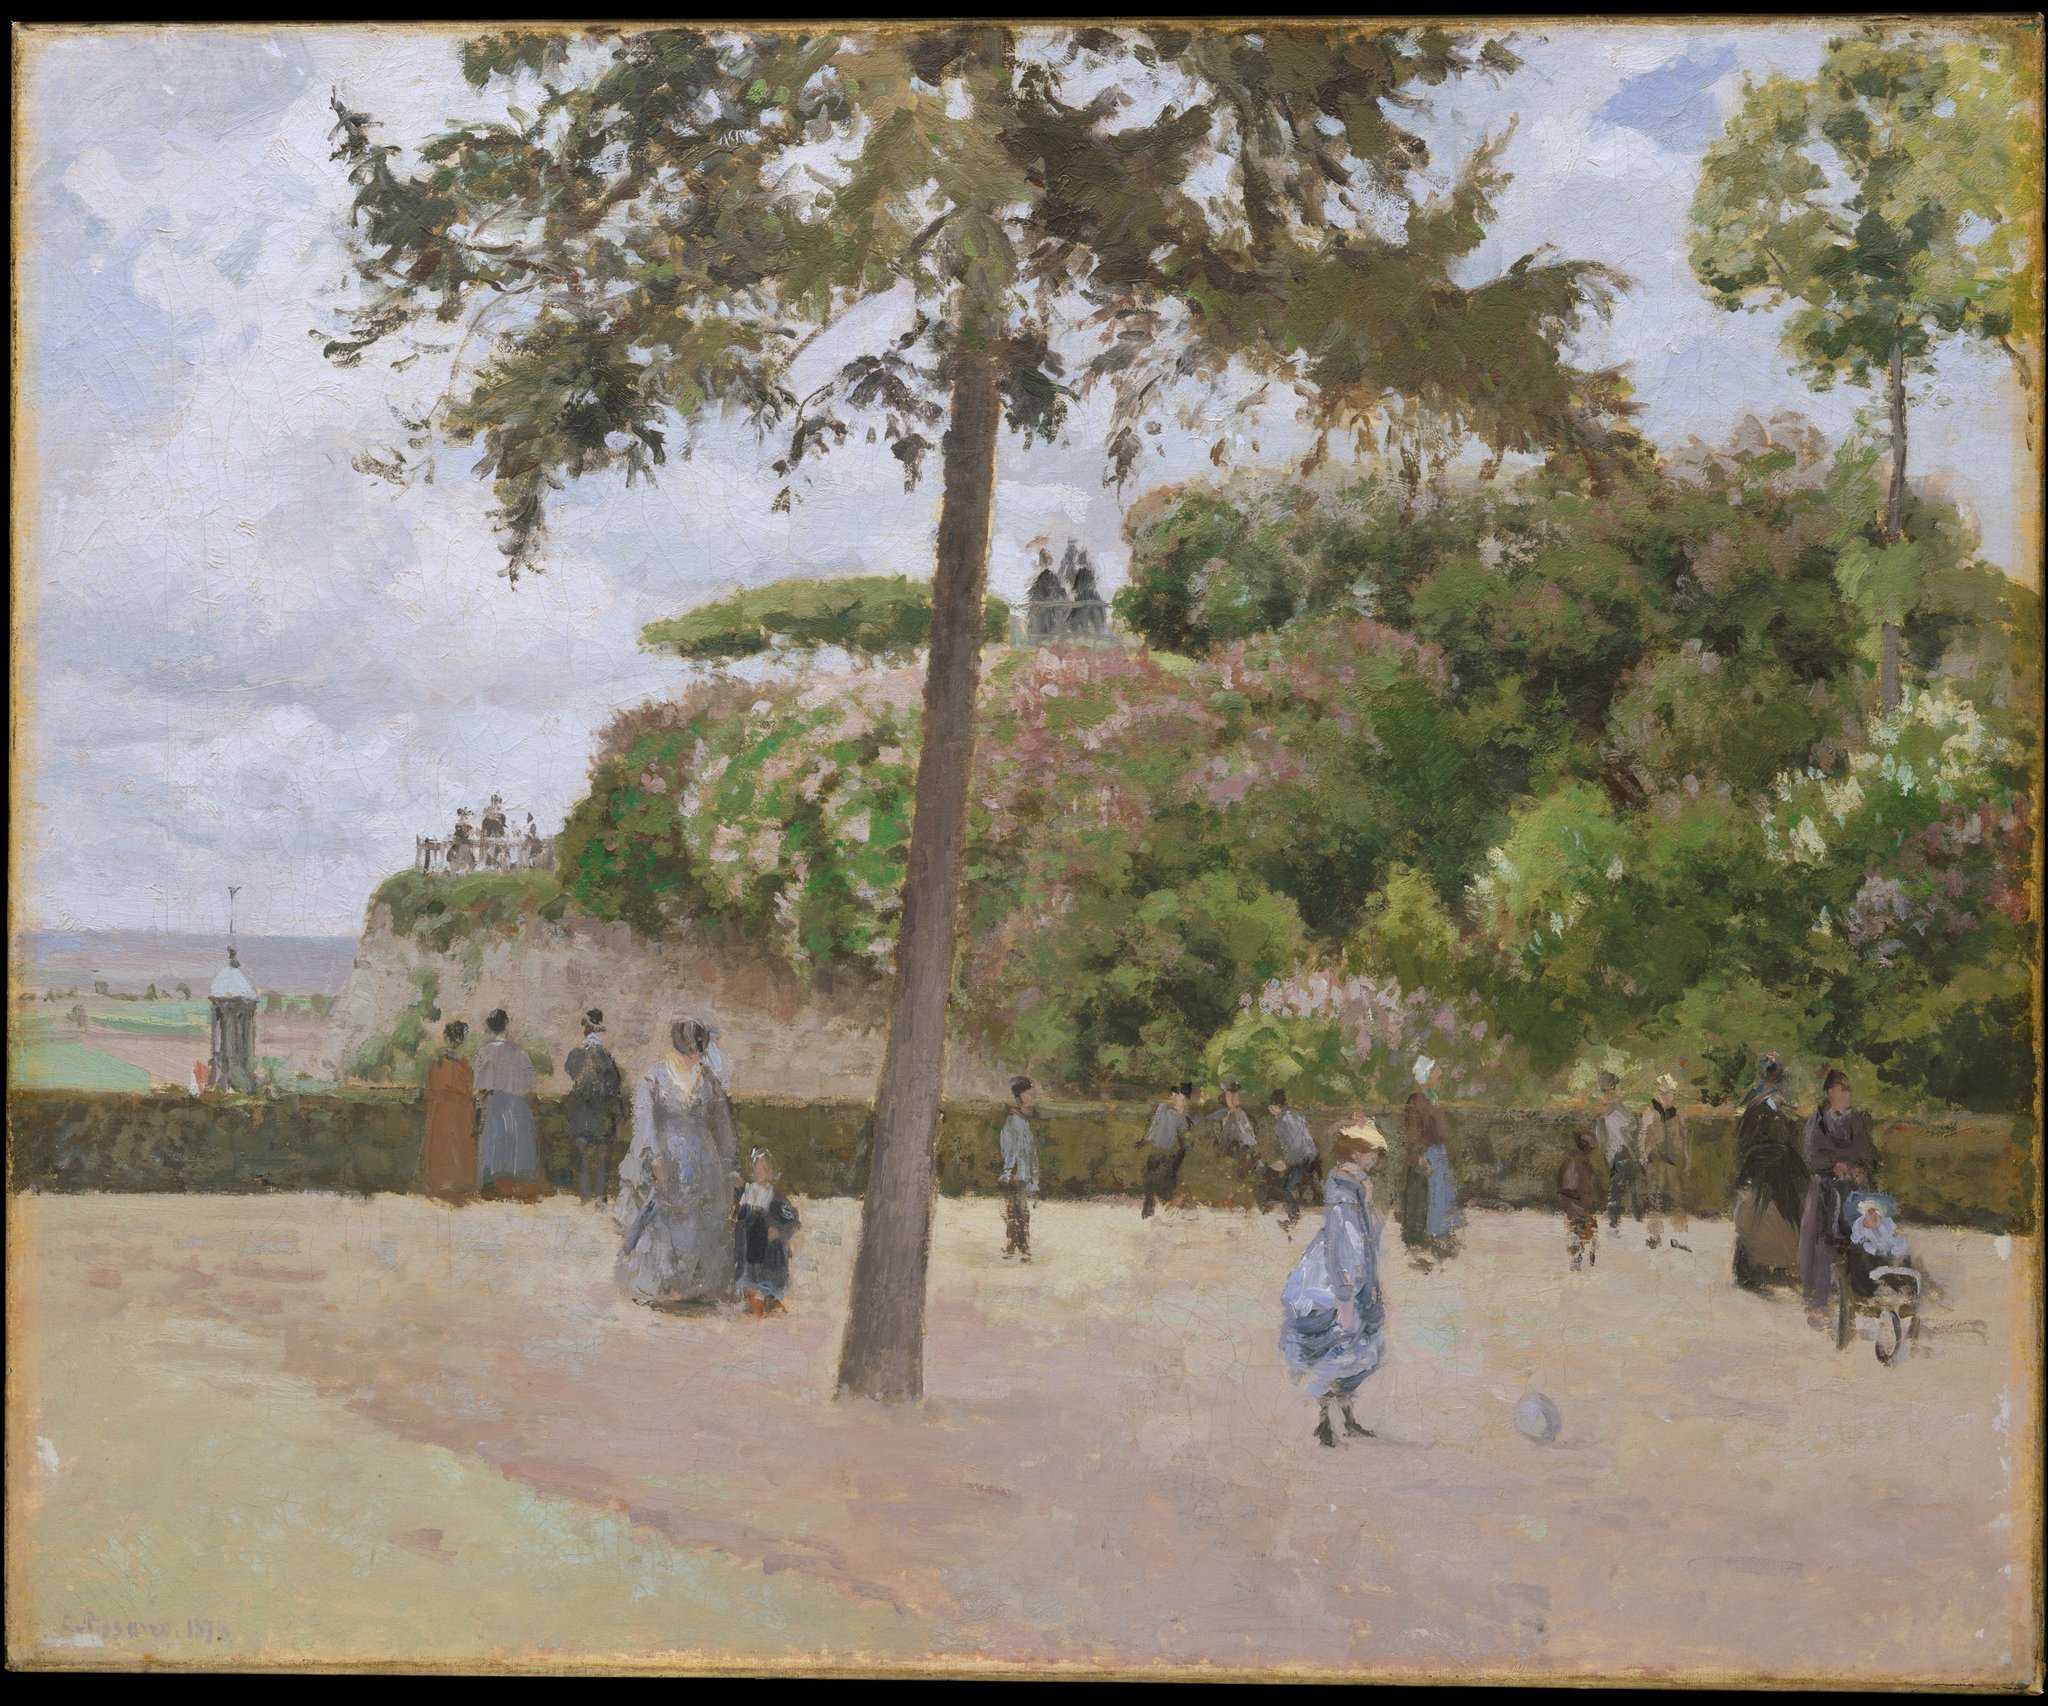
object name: painting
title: The Public Garden at Pontoise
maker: camille pissarro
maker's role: artist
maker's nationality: french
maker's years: 1830-1903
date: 1874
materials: canvas, oil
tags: human figures,gardens